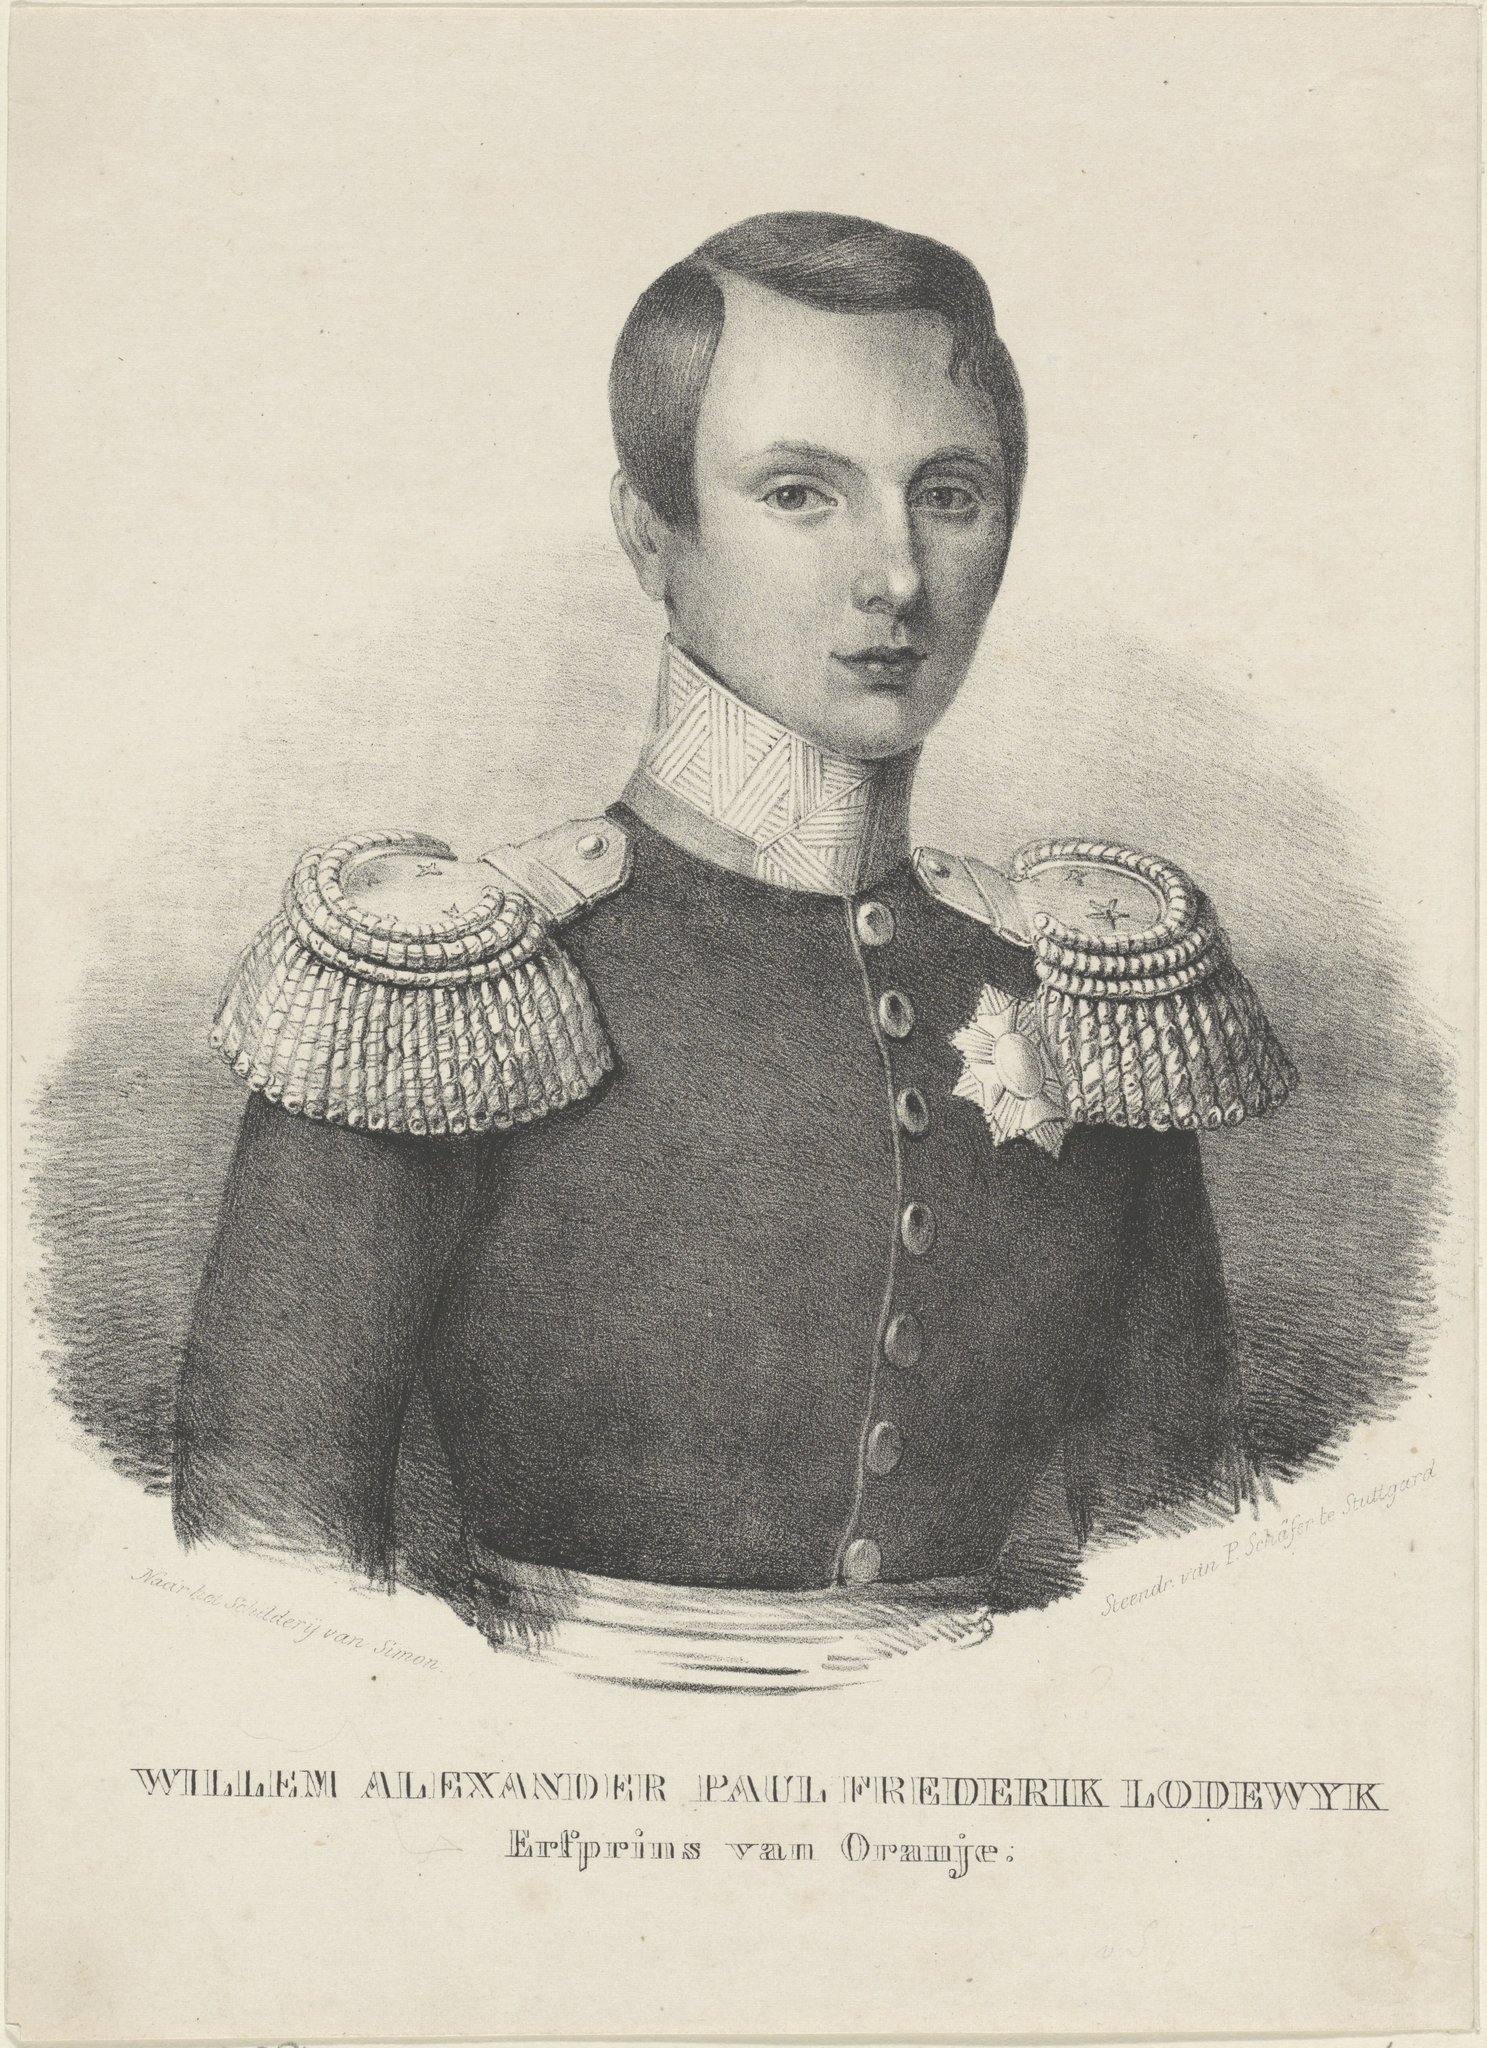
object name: print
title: Portret van Willem III, koning der Nederlanden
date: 1835-1899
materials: paper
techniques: lithograph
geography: netherlands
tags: brussels, willem iii (koning der nederlanden)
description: De hier vermelde titel verwijst naar de hoogst verkregen titel van de geportretteerde, niet per se naar de titel die de geportretteerde op deze voorstelling draagt.